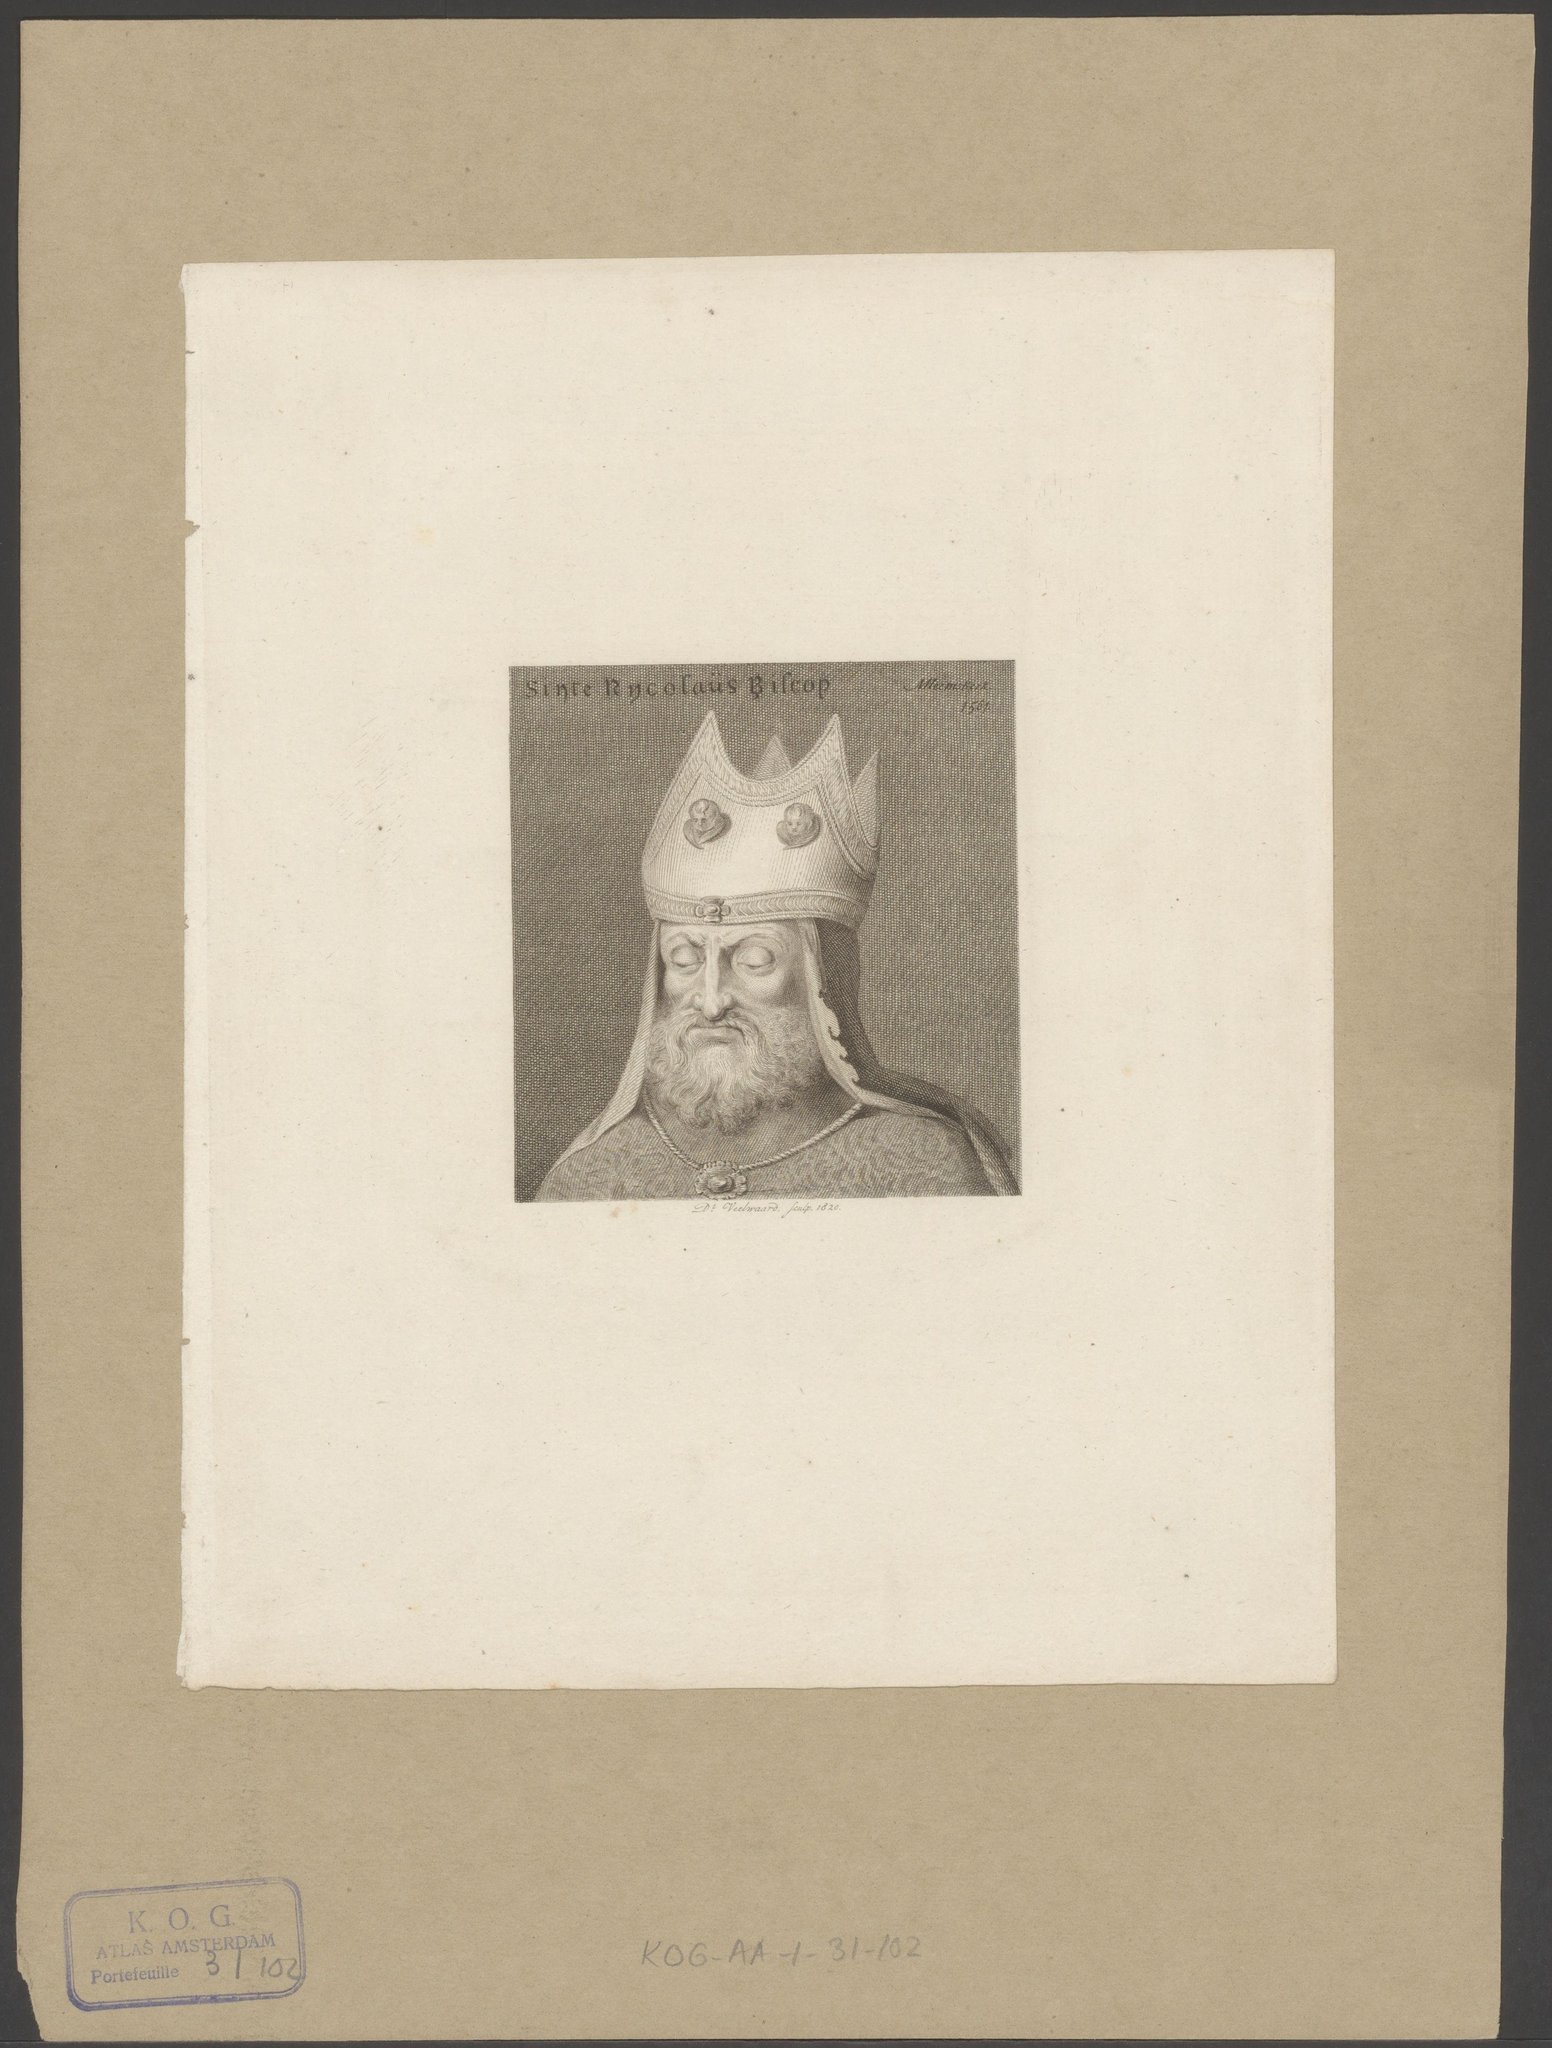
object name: print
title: Sint-Nicolaas van Myra of Joodse hogepriester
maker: martinus van heemskerck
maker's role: draughtsman, painter, print maker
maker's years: 1498-1574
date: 1820-1821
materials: paper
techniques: engraving, etching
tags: nicolaas van lyra, the bishop nicholas of myra (or bari); possible attributes: anchor, boat, three golden balls (on a book), three purses, three children in a tub, three maidens, high priest ~ hierarchy of priests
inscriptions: collector's mark: ‘31.102’ Lugt 1641b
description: Prent waarschijnlijk uit: Verhandelingen der Tweede Klasse van het Koninklijk-Nederlandsche Instituut van Wetenschappen, Letterkunden, en Schoone Kunsten te Amsterdam. Amsterdam: Pieper & Ipenbuur, 1821, dl. 2. Prent ook gepubliceerd in: De merkwaardigste stukken uit de oudste archieven van Amsterdam, aangaande de vroegere privilegiën, van deszelfs poorters en inwoners. Amsterdam: Pieper & Ipenbuur, 1821.